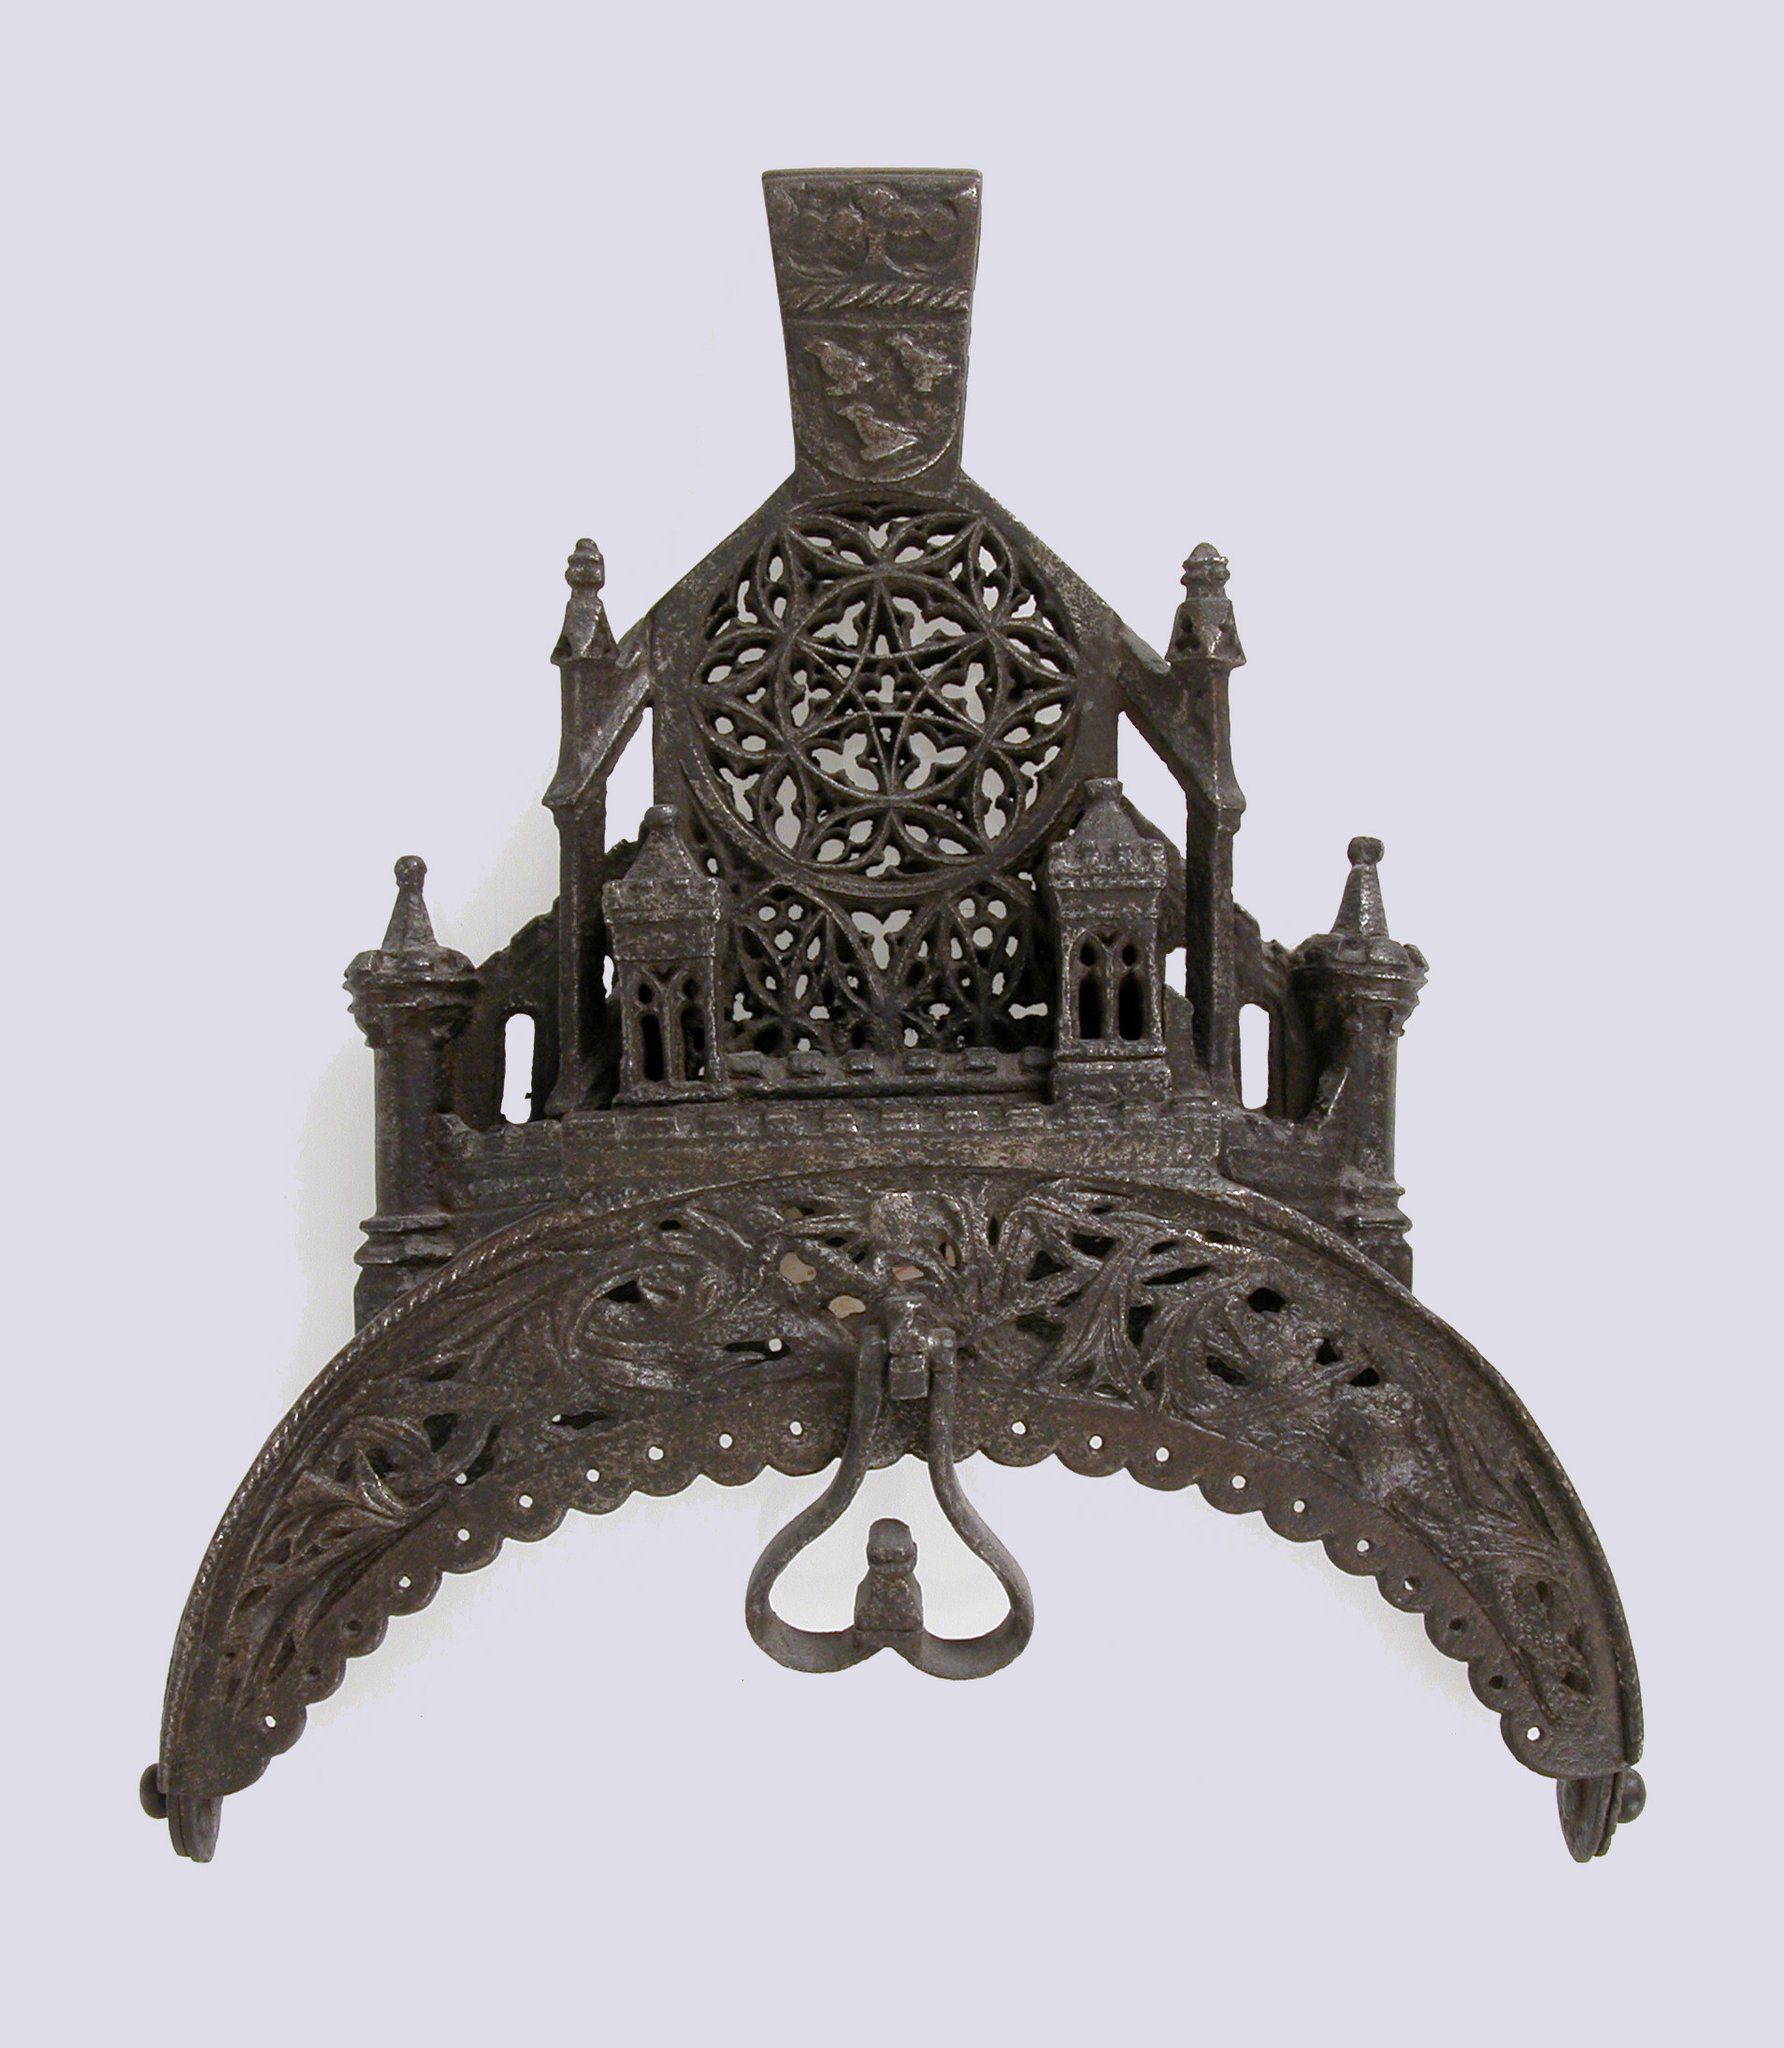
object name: purse frame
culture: french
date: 1401-1600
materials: iron